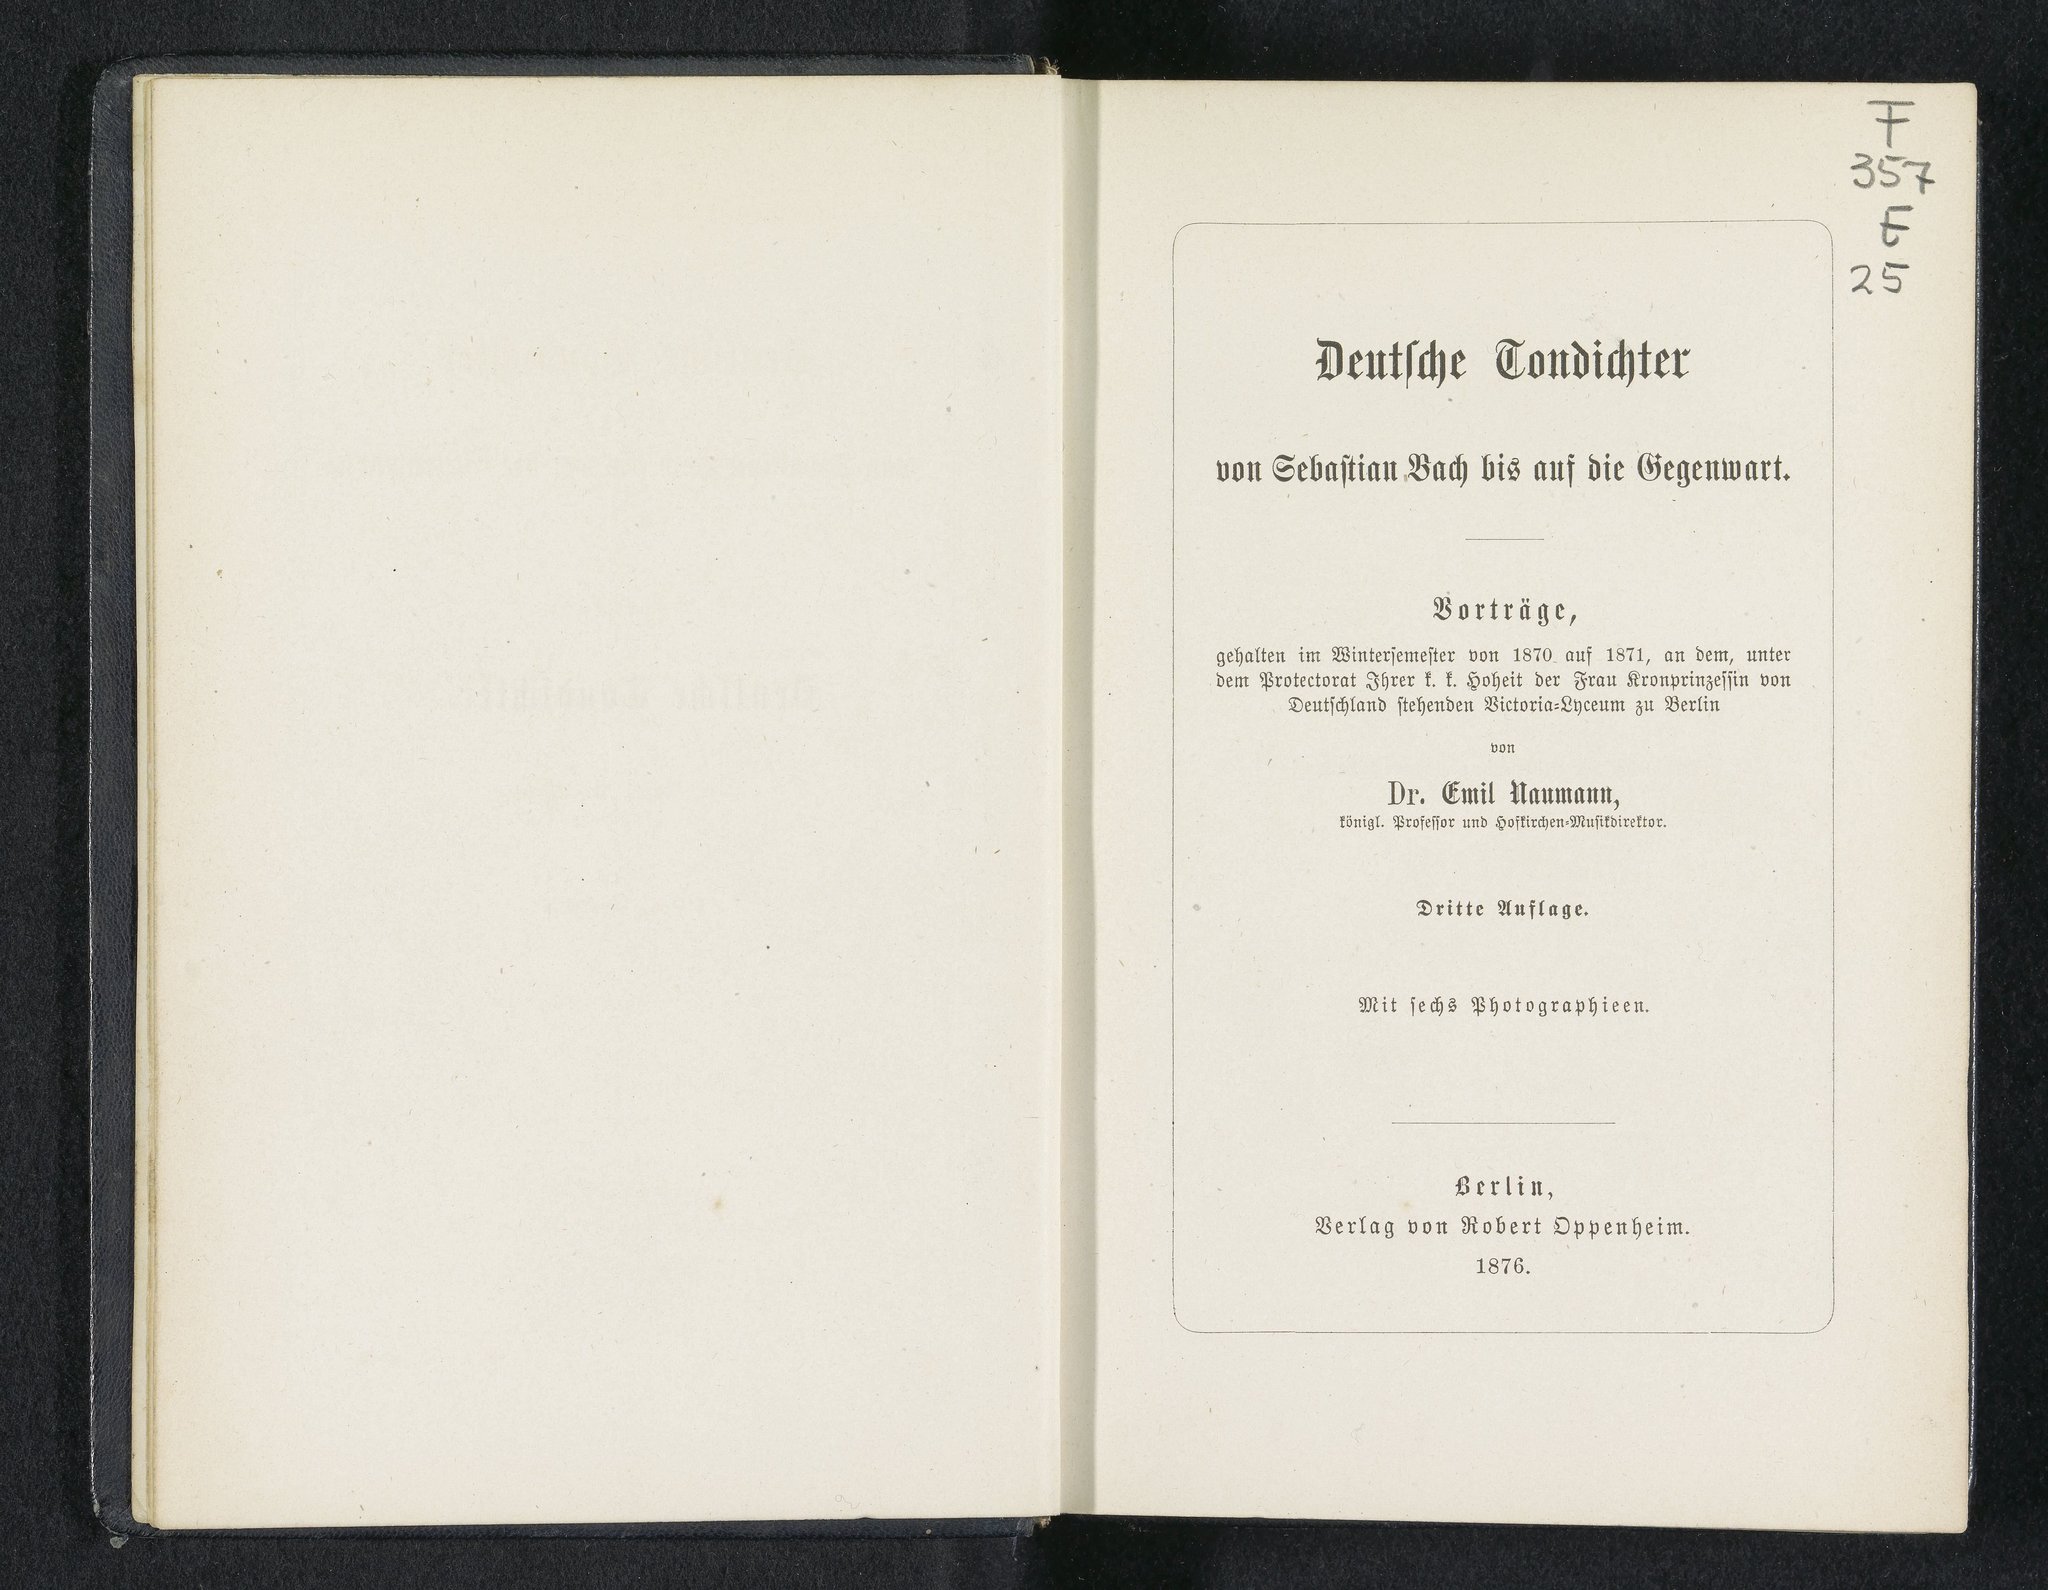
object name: book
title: Deutsche Tondichter von Sebastian Bach bis auf die Gegenwart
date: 1876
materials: cardboard, leather, paper, photographic support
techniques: albumen print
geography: berlin